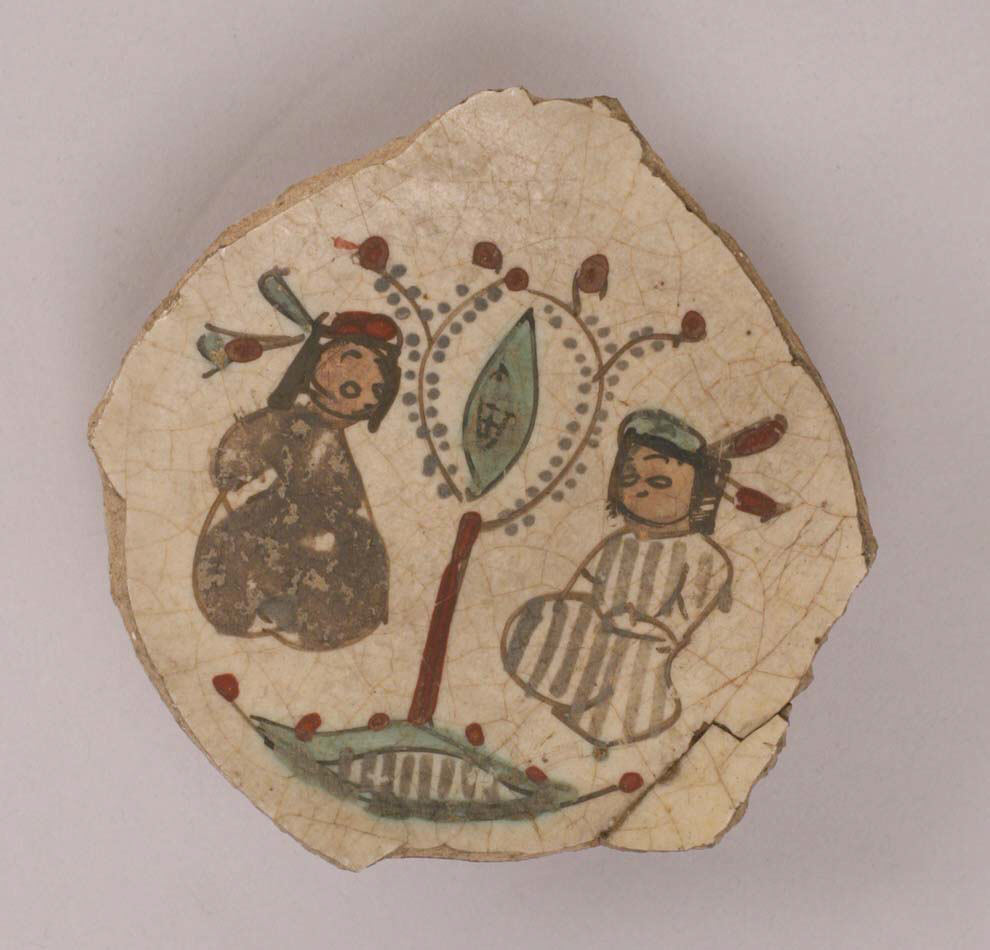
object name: fragment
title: Fragment of a Bowl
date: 1101-1300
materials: stonepaste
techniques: overglaze, painting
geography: iran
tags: men,women